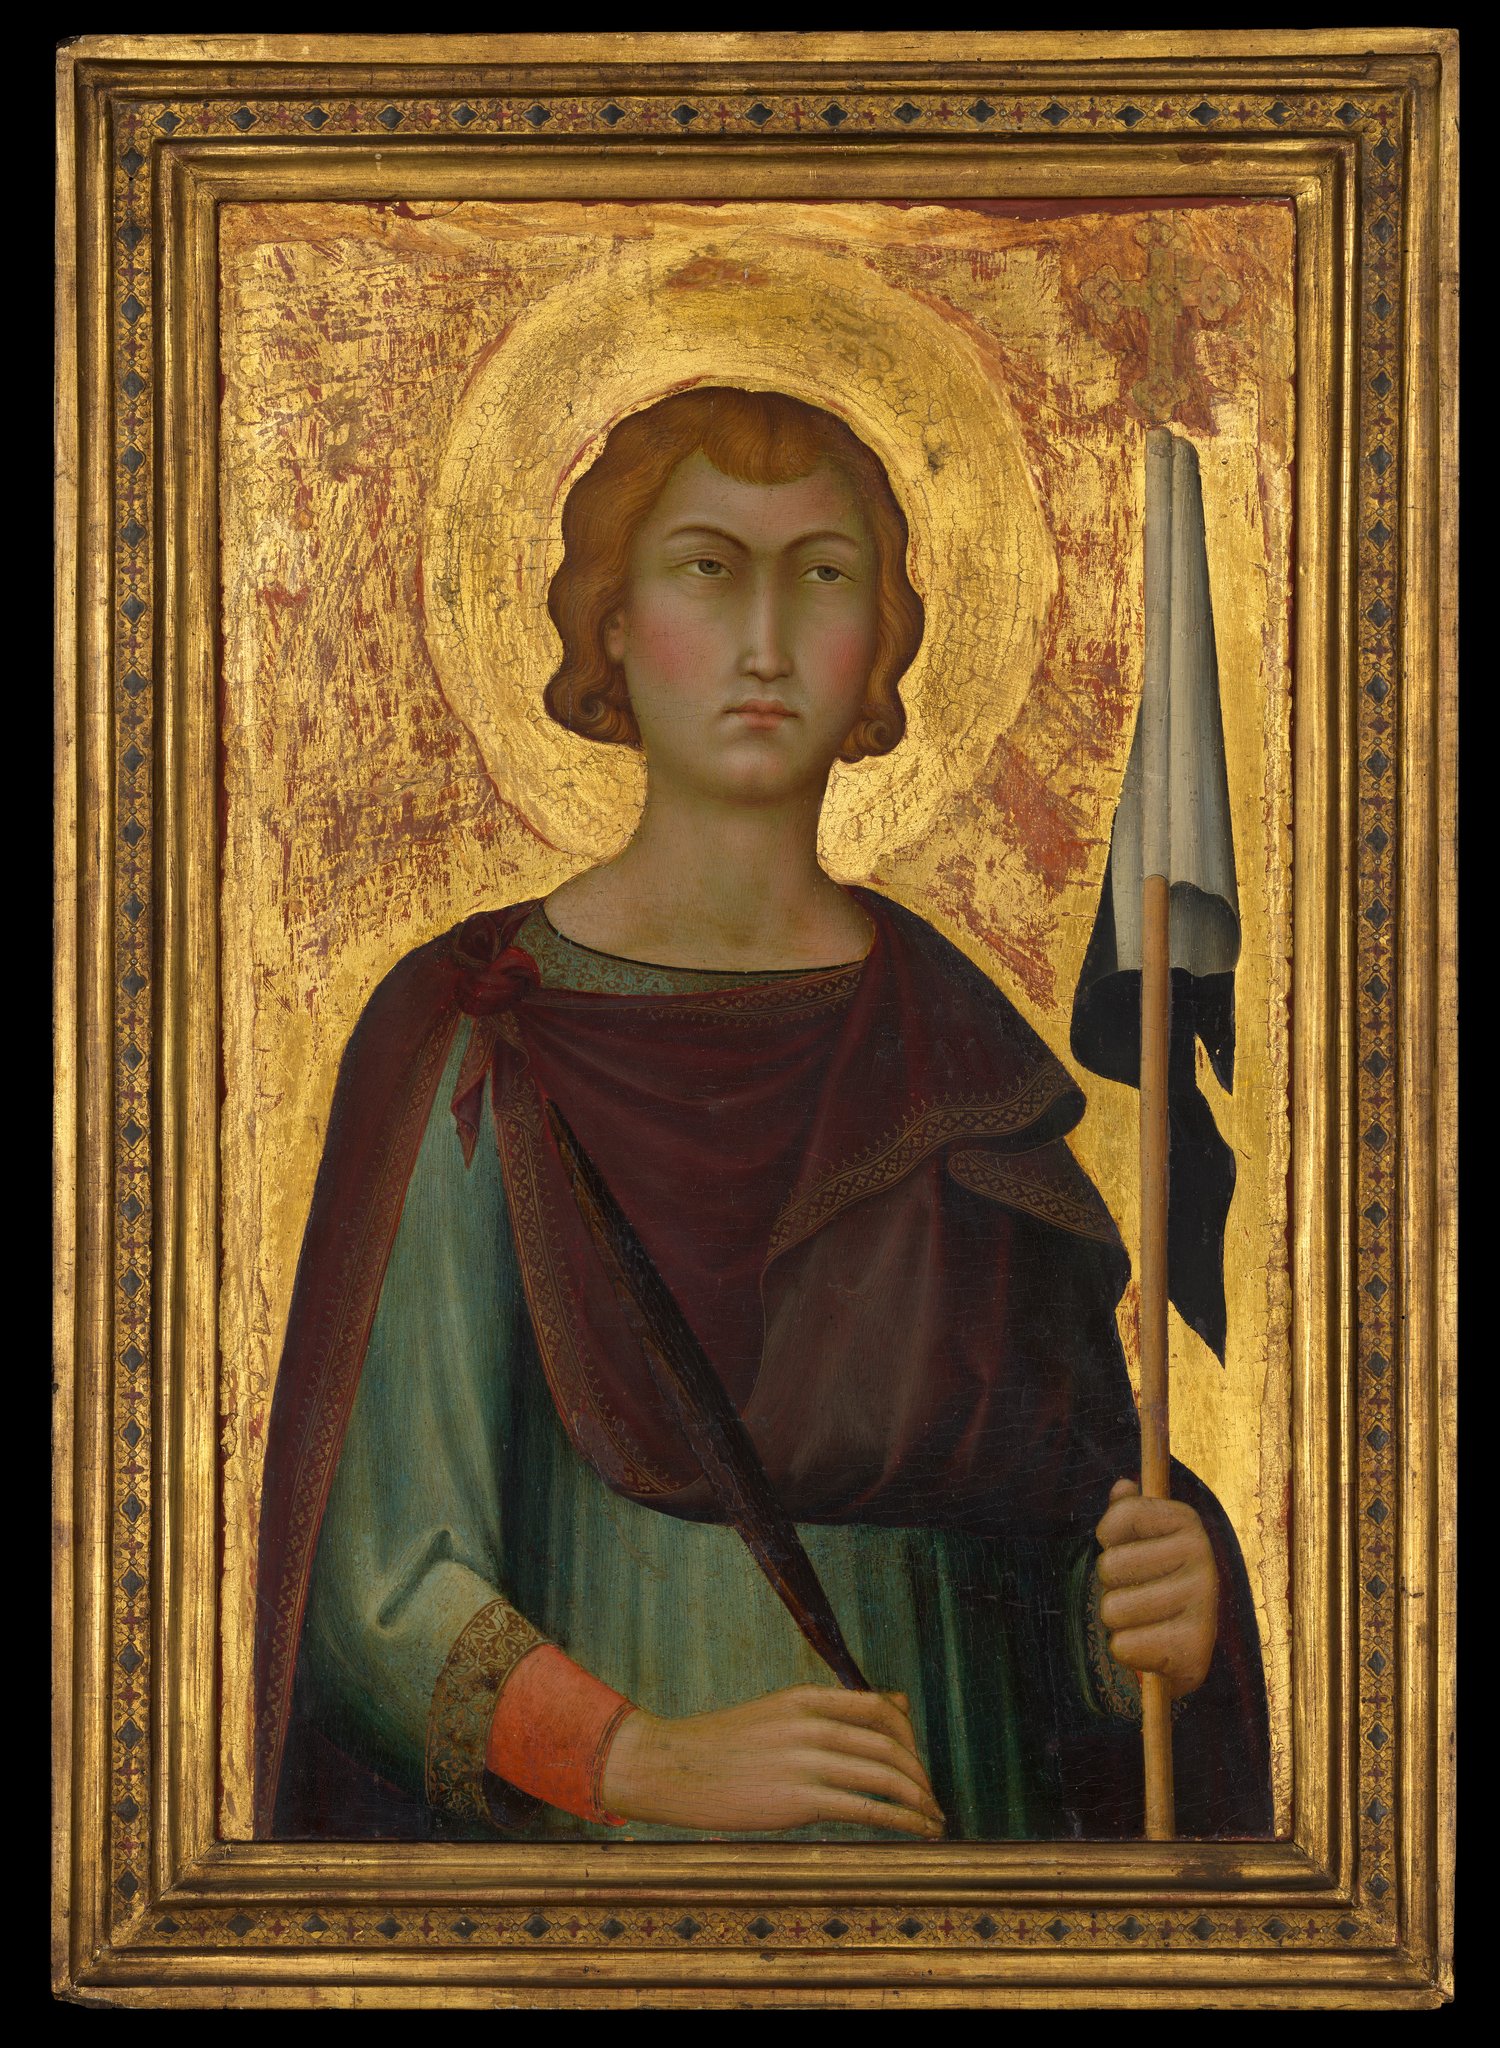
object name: painting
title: Saint Ansanus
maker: simone martini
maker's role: artist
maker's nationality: italian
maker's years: 1315-1344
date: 1326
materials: gold leaf, paint, wood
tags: men,saints